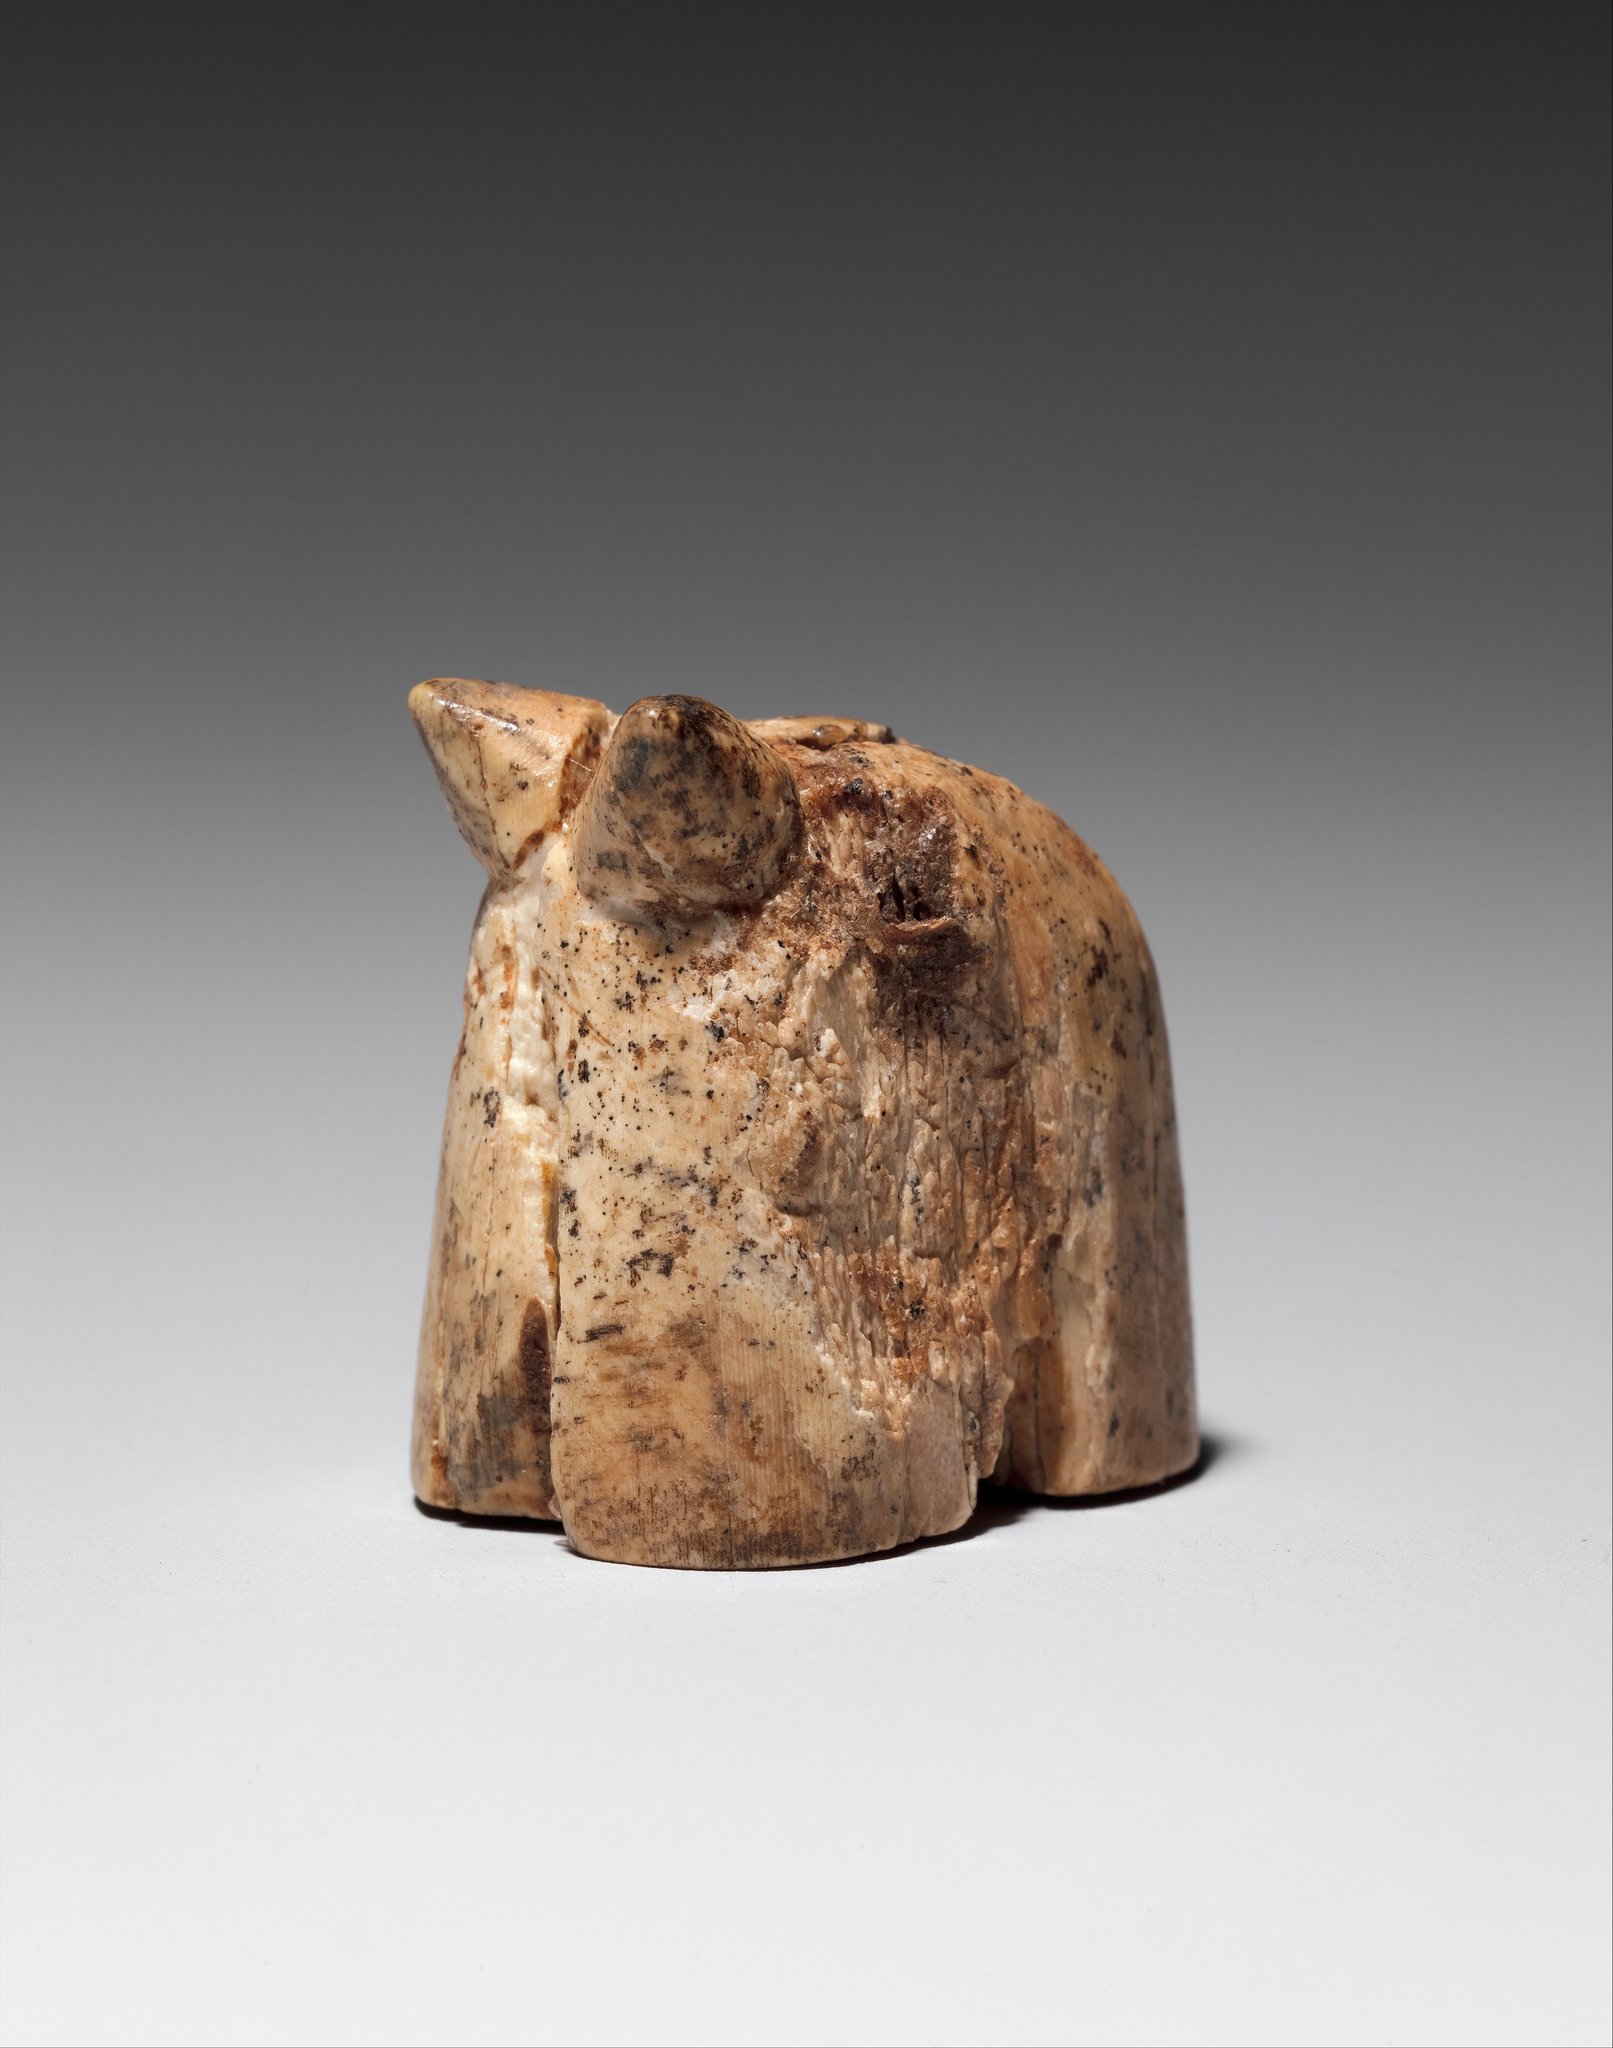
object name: chess piece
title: Chess Piece, Bishop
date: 801-1200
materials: ivory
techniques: carving, painting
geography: iran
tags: chess